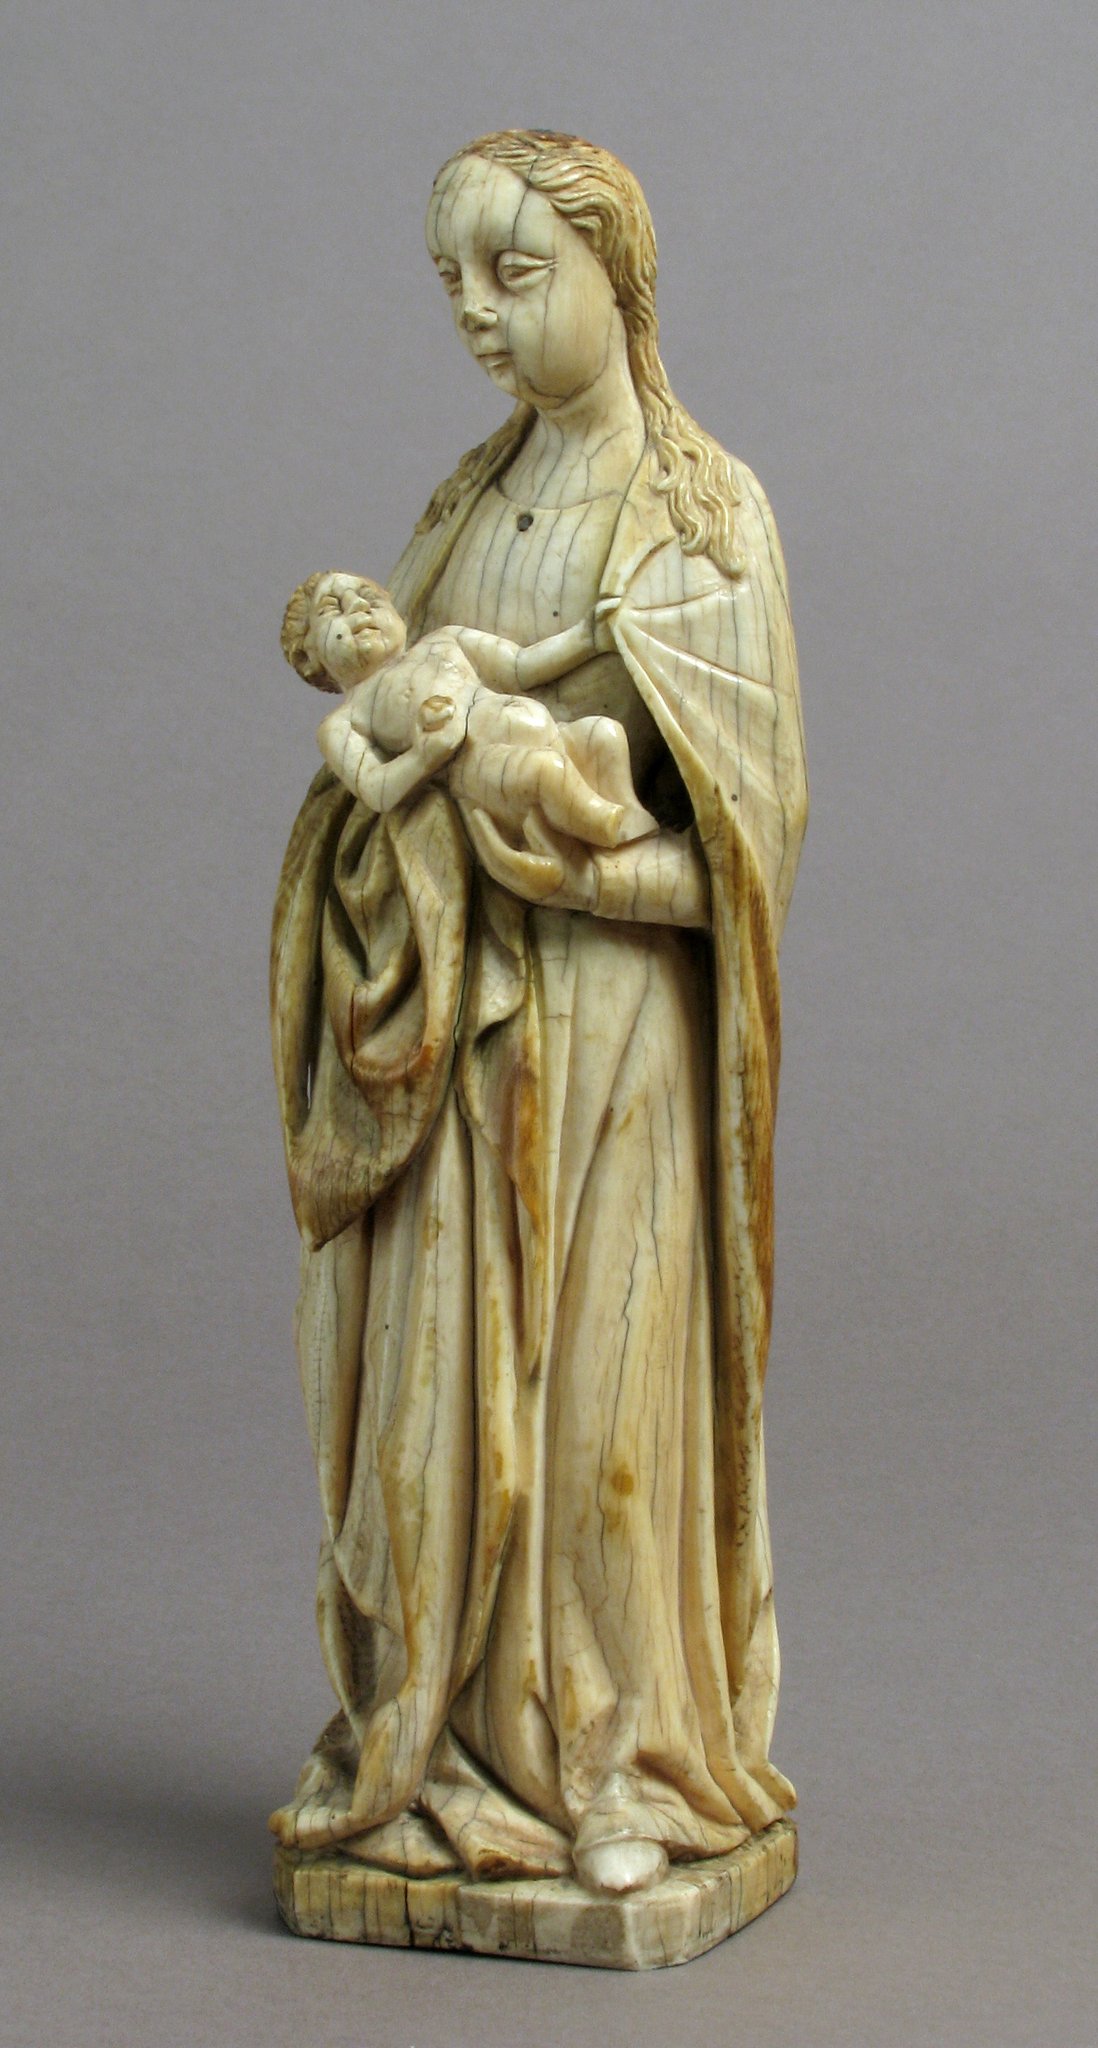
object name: statuette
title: Virgin and Child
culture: french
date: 1401-1600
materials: gilt copper, ivory